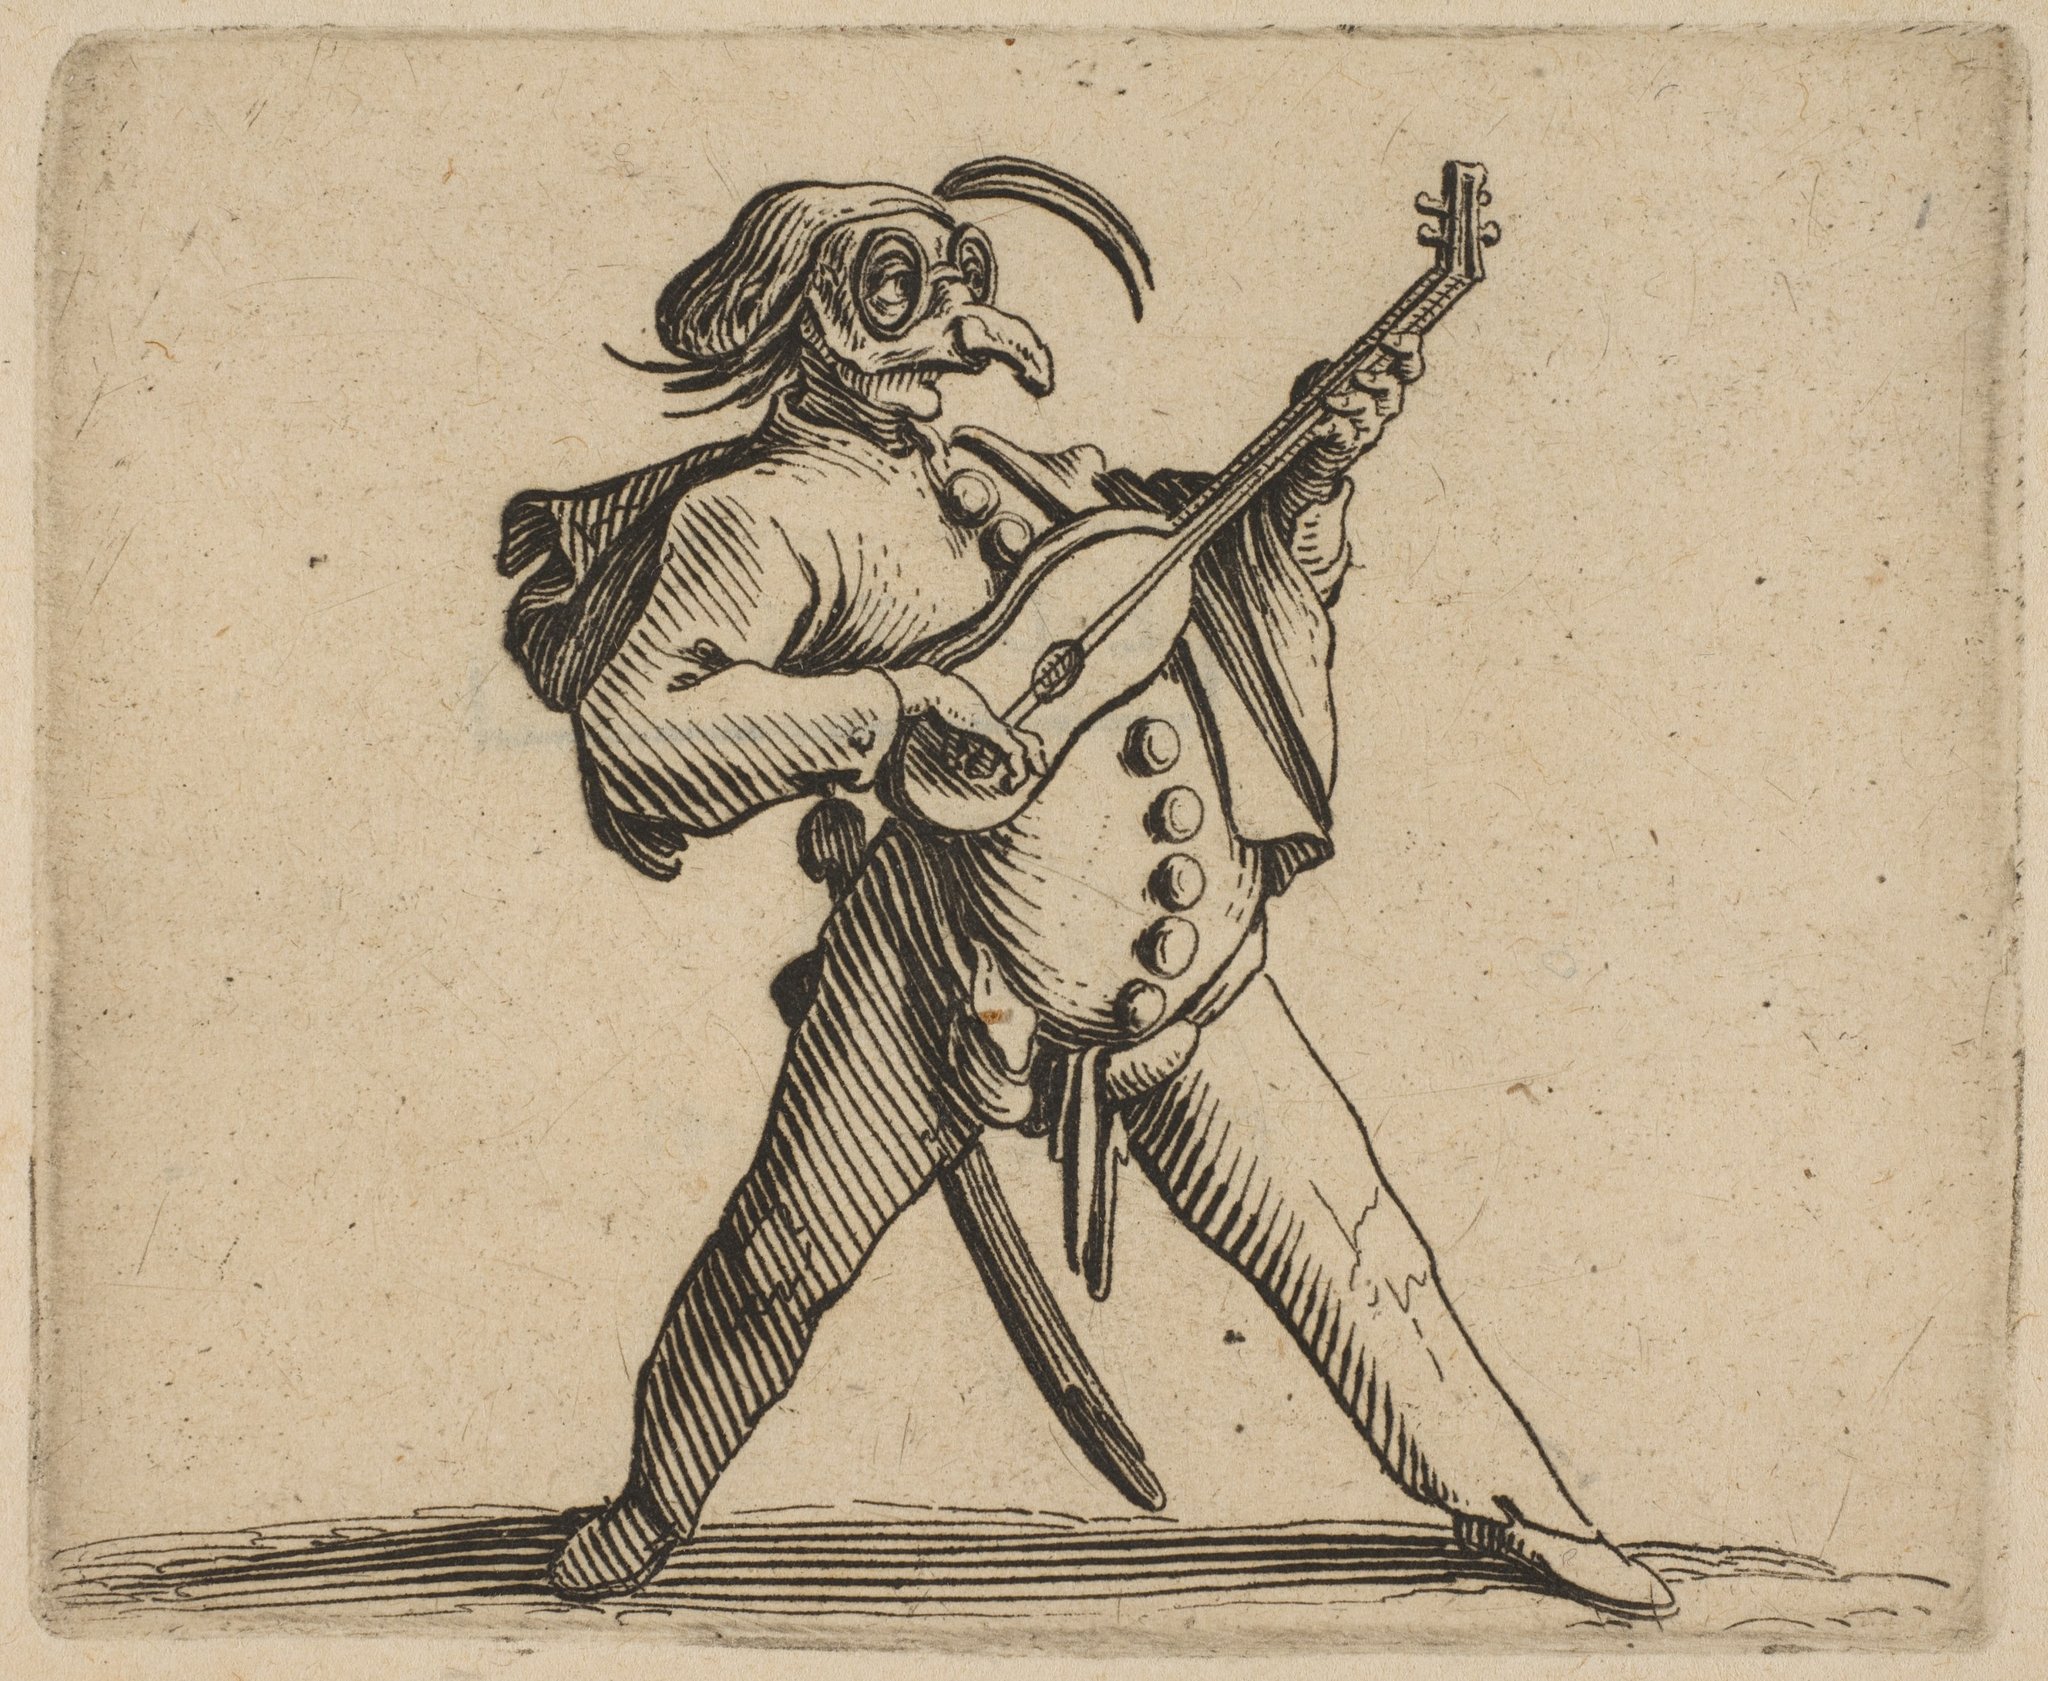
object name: print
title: Le Comédien Masqué Jouant de la Guitare (The Masked Comedian Playing the Guitar), from "Varie Figure Gobbi, suite appelée aussi Les Bossus, Les Pygmées, Les Nains Grotesques" (Various Hunchbacked Figures, The Hunchbacks, The Pygmes, The Grotesque Dwarfs)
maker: jacques callot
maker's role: artist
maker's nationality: french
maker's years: 1592-1635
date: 1616-1622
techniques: engraving, etching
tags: masks,guitars,musicians